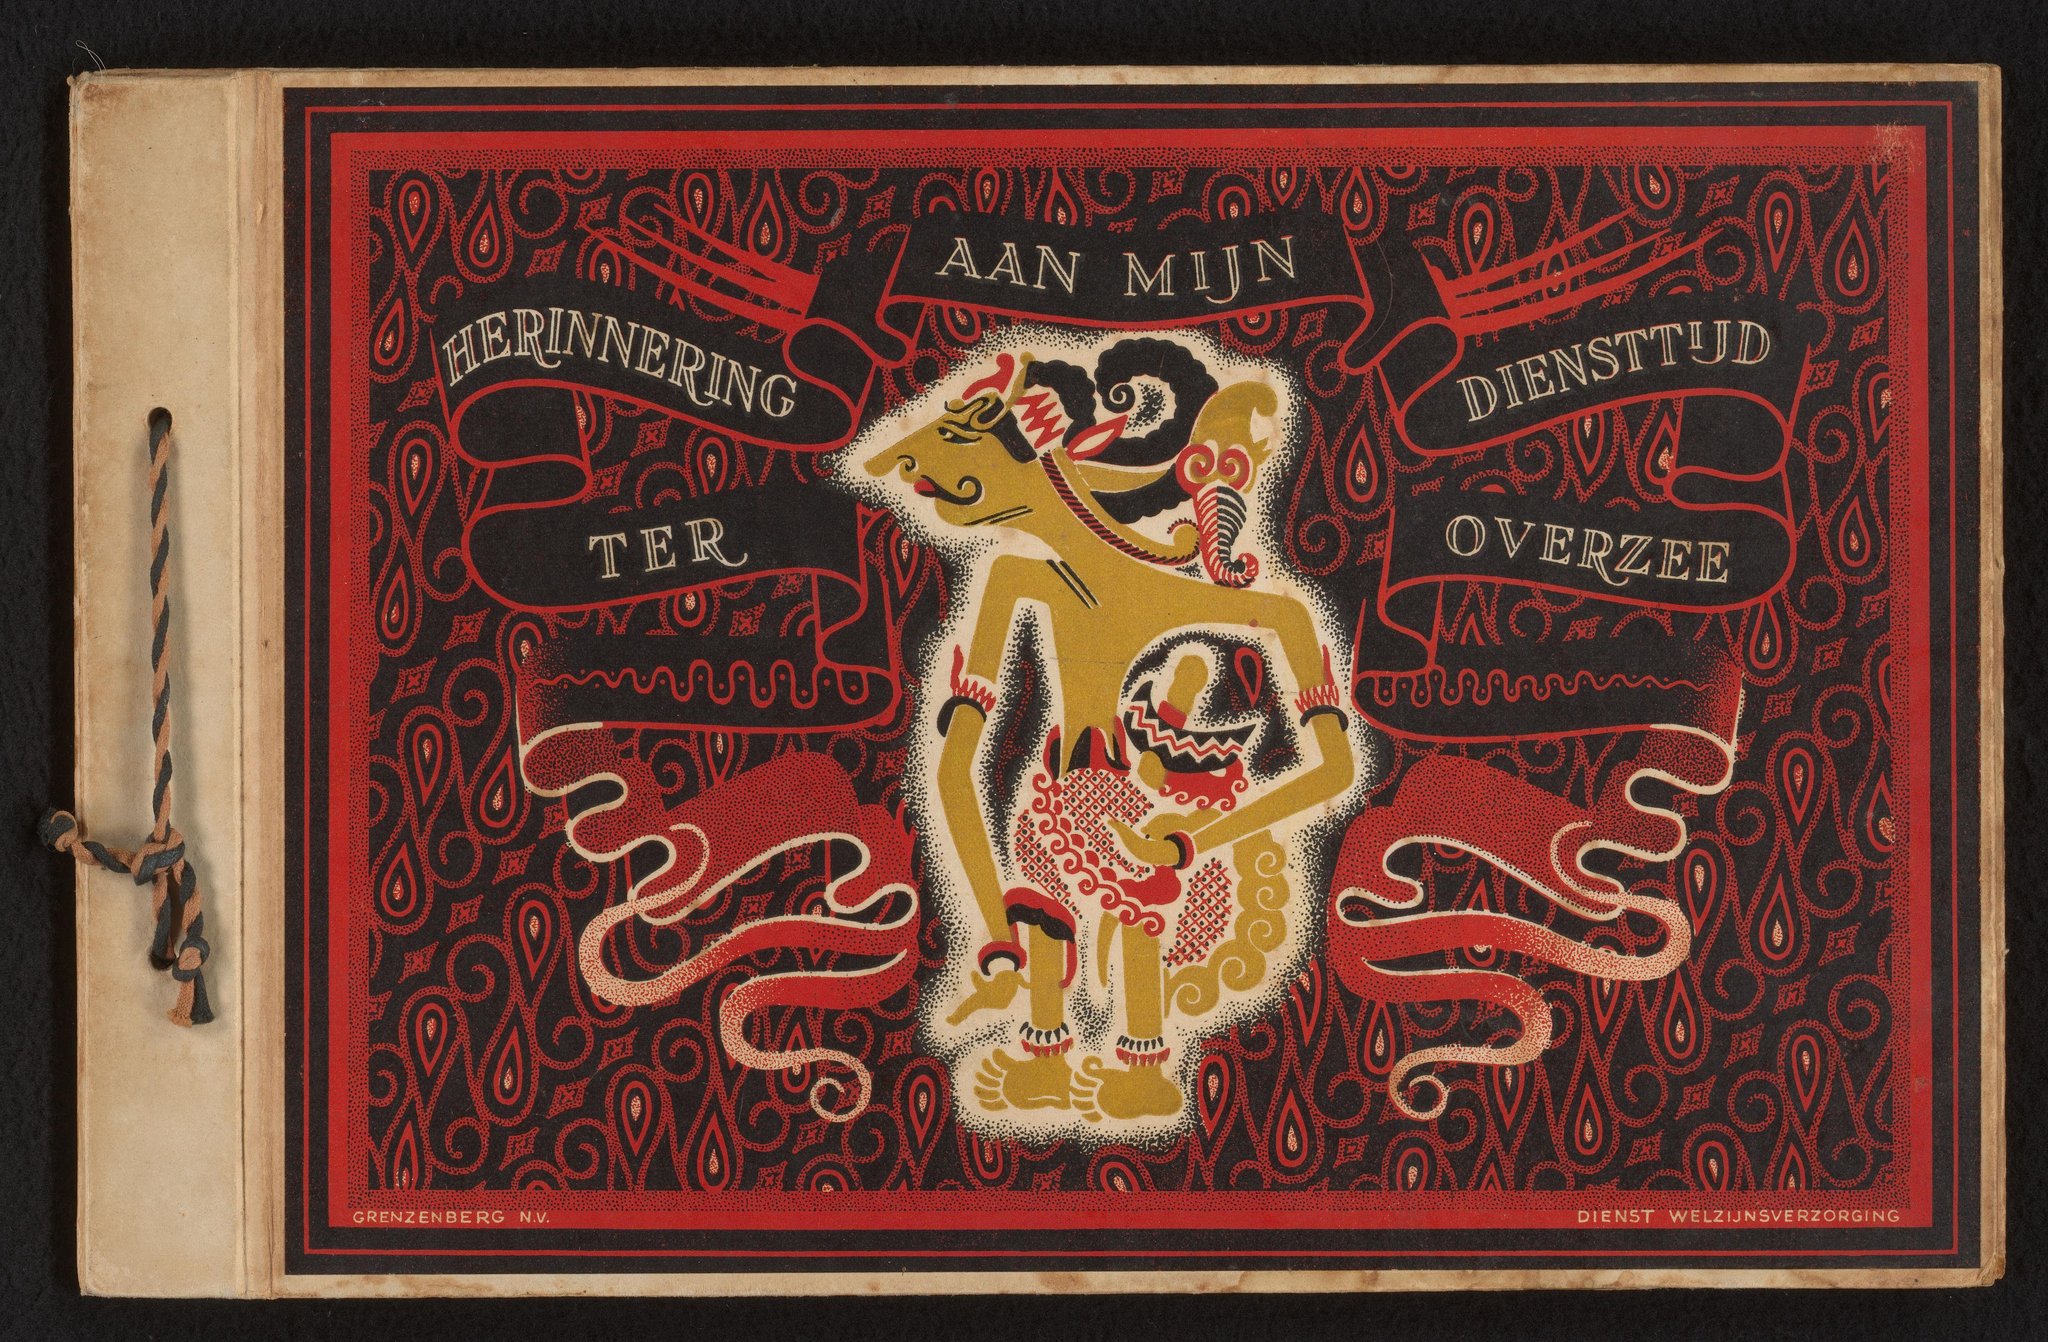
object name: photograph album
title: Ter herinnering aan mijn diensttijd overzee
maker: Anonymous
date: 1948-1949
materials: cardboard, paper, photographic support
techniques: gelatin silver print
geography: dutch east indies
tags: dutch east indies, the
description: Fotoalbum met 12 bladen met tussenvellen van satijnpapier en 120 foto's over de dienststijdvan een Nederlandse militair in Nederlands-Indië in de jaren 1948-1949. Het album is vermoedelijk uitgereikt aan de militairen door de Dienst Welzijnsverzorging. De versierde voorkant doet denken aan de batik techniek. In het midden een voorstelling van een Wajangpop, er omheen geometrische figuren met in een soort guirlande de tekst: Ter herinnering aan mijn diensttijd overzee. Aan de binnenkant van de kaft zit een kleine portretfoto, waarschijnlijk de - onbekende - eigenaar van het album op latere leeftijd. Op de foto's staan geen oorlogshandelingen, wel patrouilles, het dagelijks leven van de militair en de omgang met de lokale bevolking. Op veel foto's staat achterop iets geschreven en een datum, tussen juli 1948 en mei 1949.